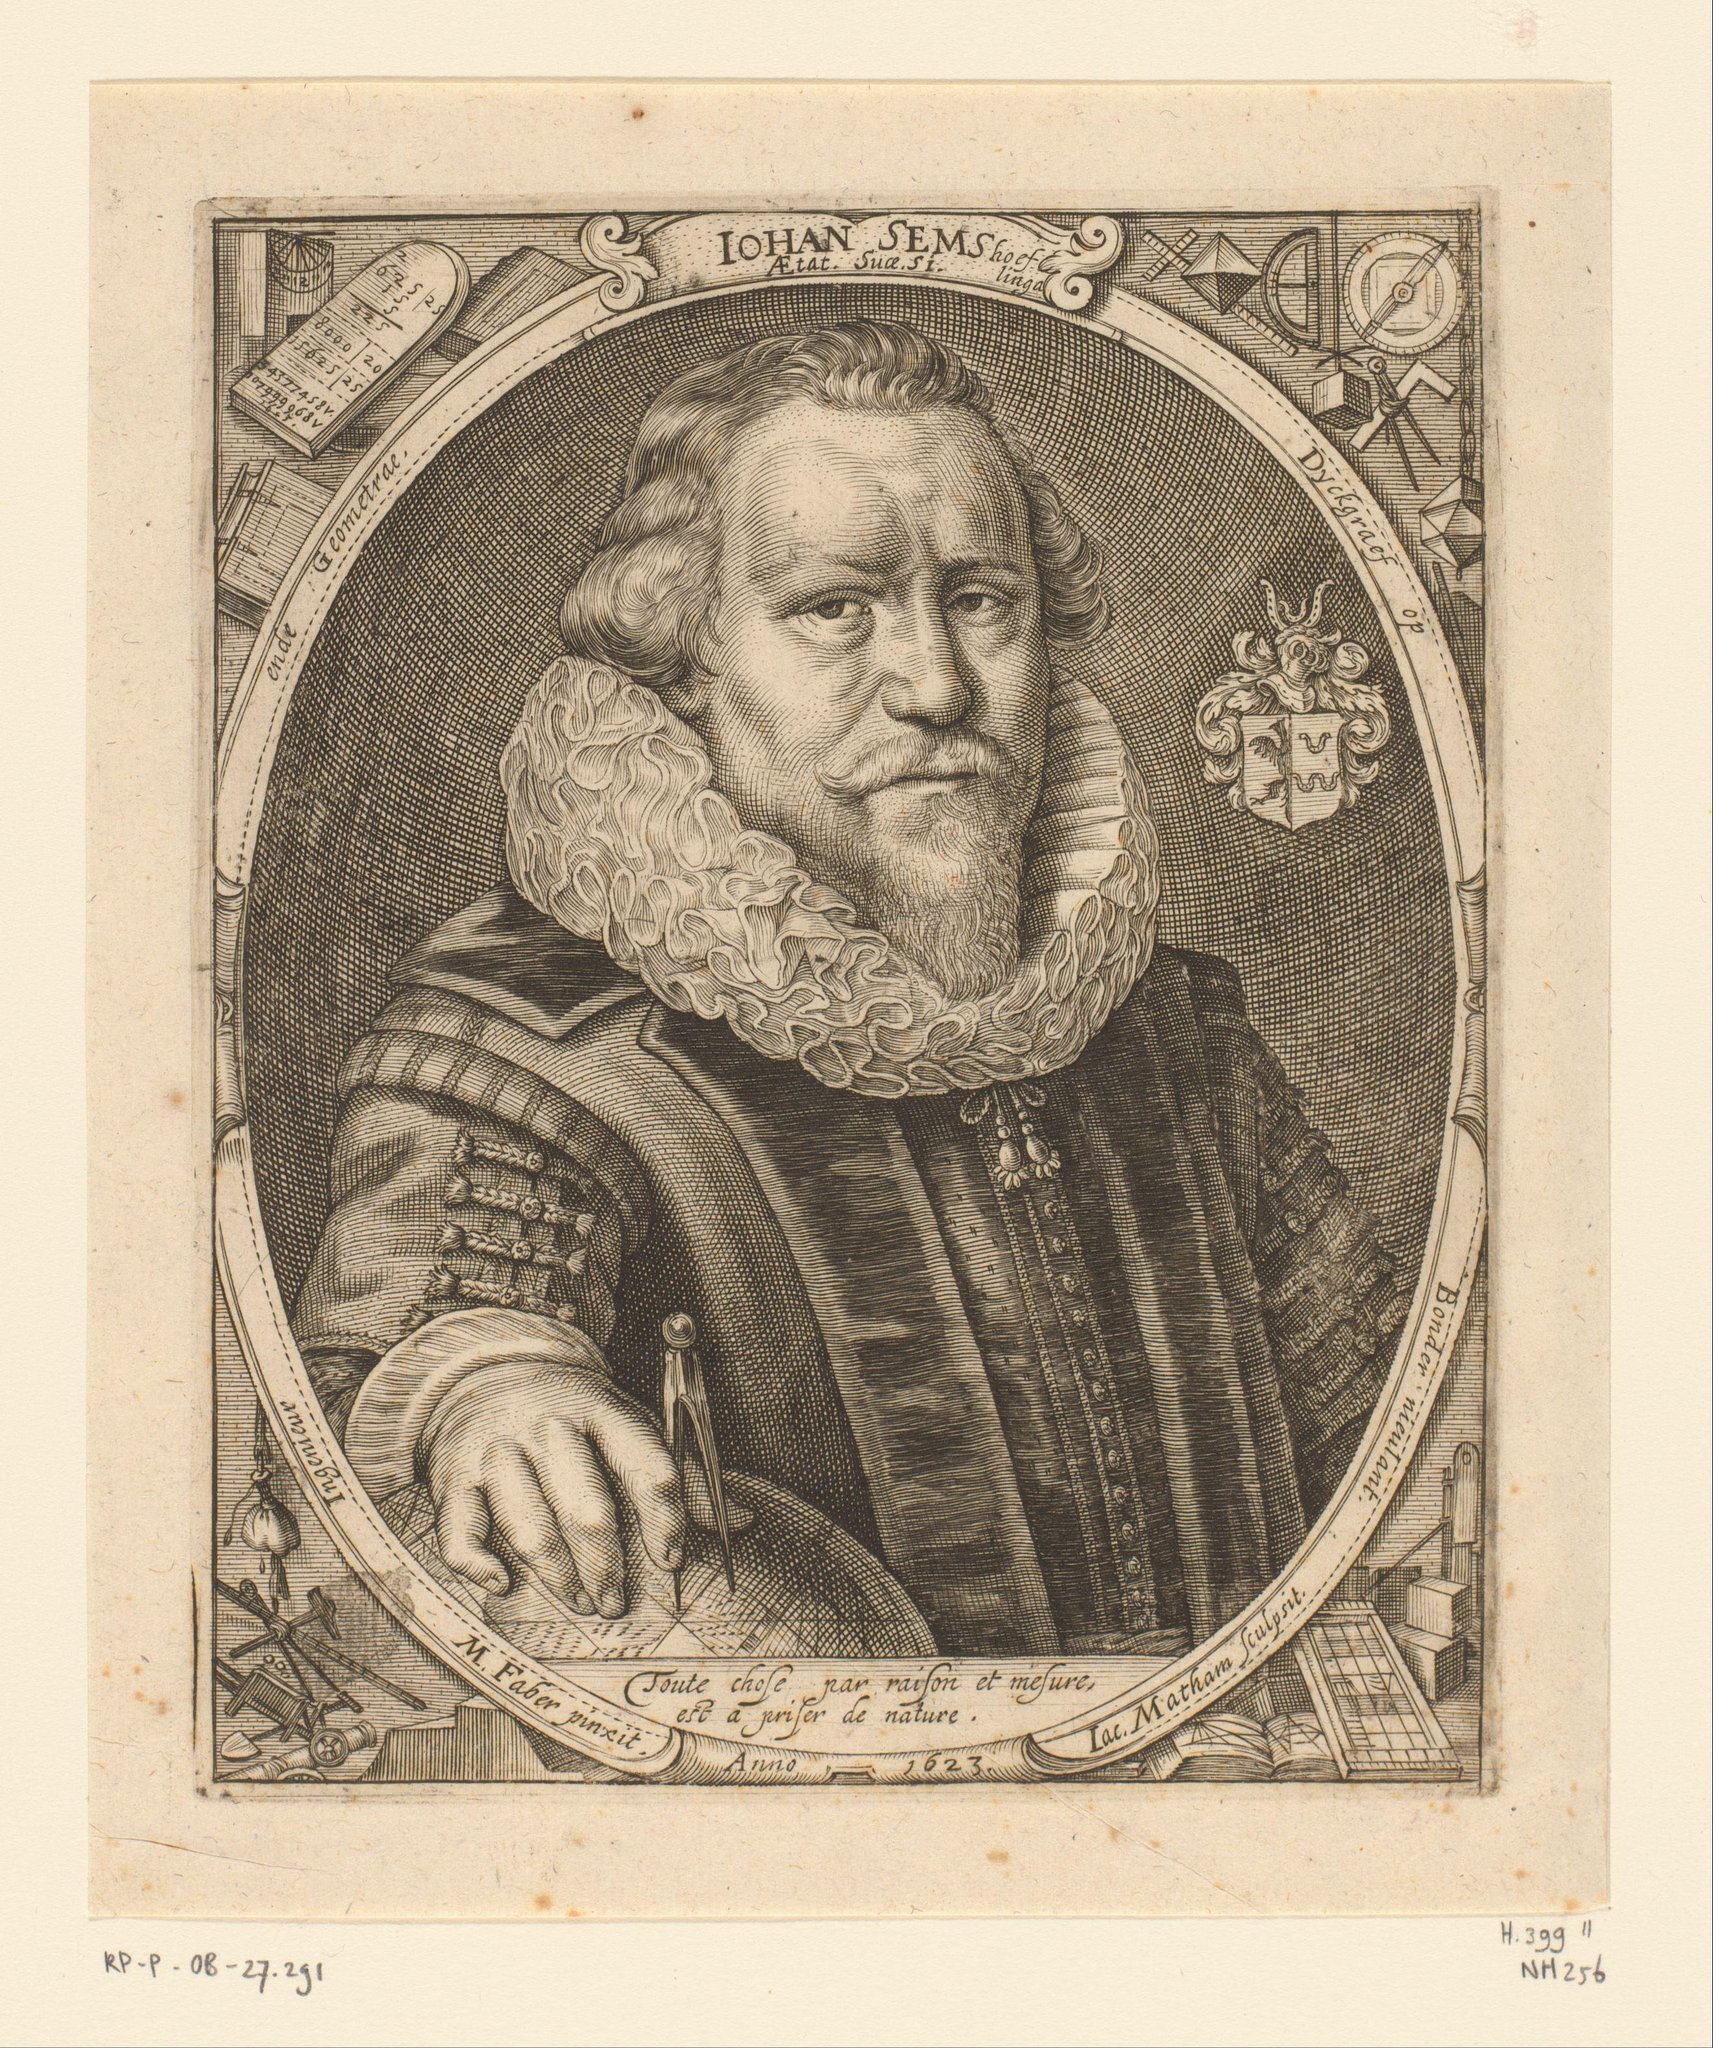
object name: print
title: Portret van Johan Sems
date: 1623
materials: paper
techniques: engraving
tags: johan sems, land registry, moustache, historical persons, mathematics (+ portrait of scholar, scientist), beard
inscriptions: collector's mark: Lugt 240, inscription: ‘Toute chose paraison et mesure est à priser de nature.’, signature: ‘M. Faber pinxit’, date: ‘Anno 1623’, signature: ‘Jac. Matham sculpsit’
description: Portret van Johan Sems (1572-ca.1635), landmeter en mathematicus in Groningen, op 59-jarige leeftijd. Portret ten halven lijve, 3/4 naar rechts gewend, met snor en puntbaard, gekleed in toga, met geplooide kraag. De rechterhand, waarin hij een passer houdt, rust op een aardglobe, die naast hem staat. Op de achtergrond rechts zijn wapen. In ovaal. De hoeken buiten het ovaal zijn gevuld met verschillende meetkundige en andere werktuigen.